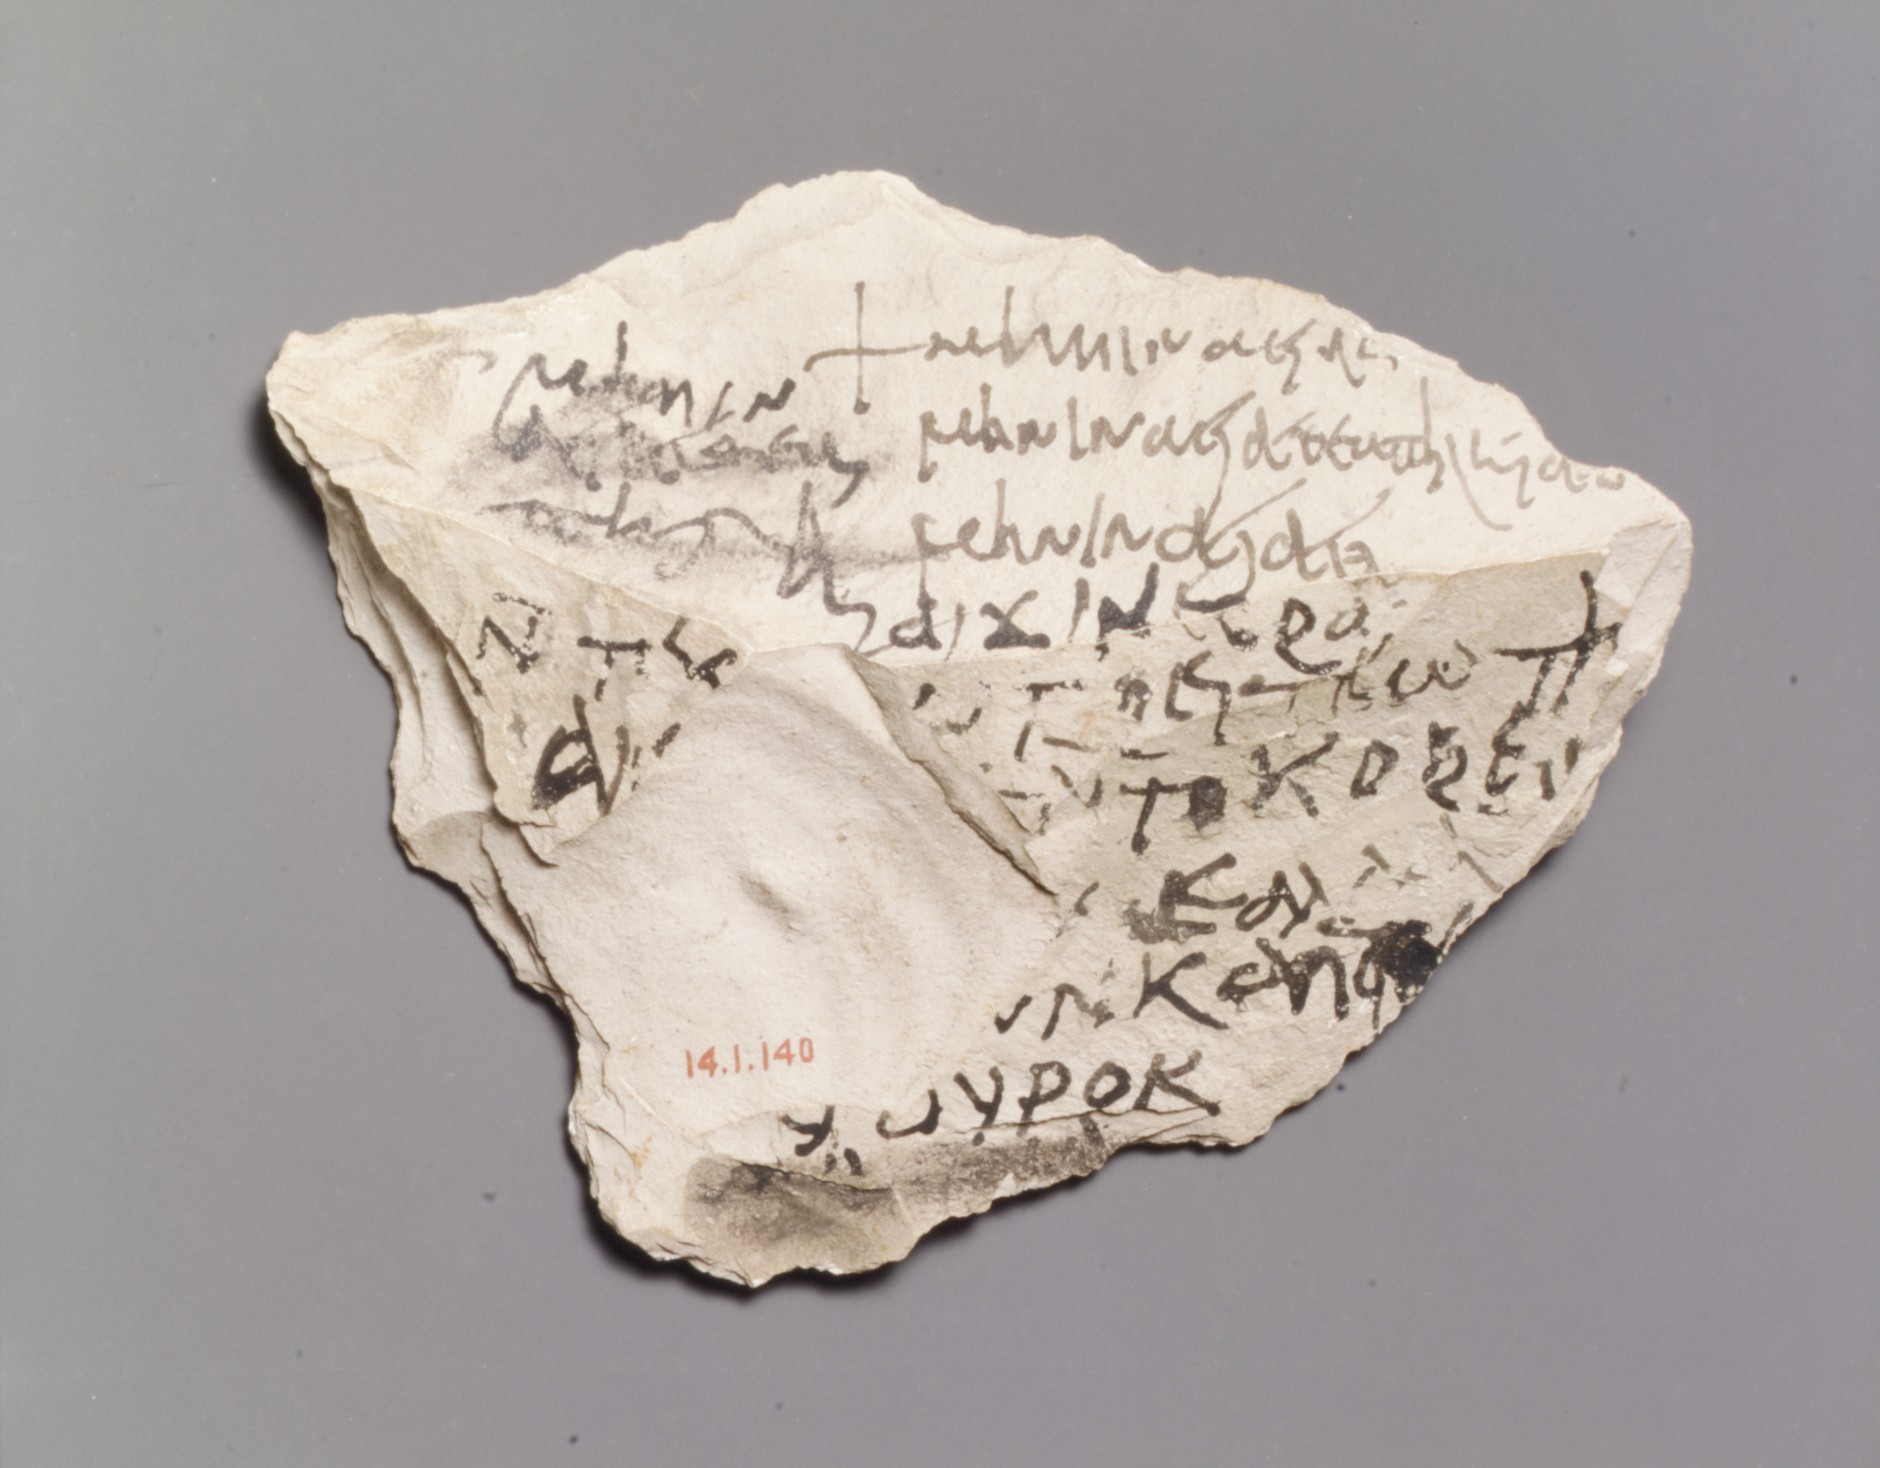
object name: ostrakon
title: Ostrakon with Lines from Homer’s Iliad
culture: coptic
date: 580-640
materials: ink, limestone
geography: egypt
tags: documents